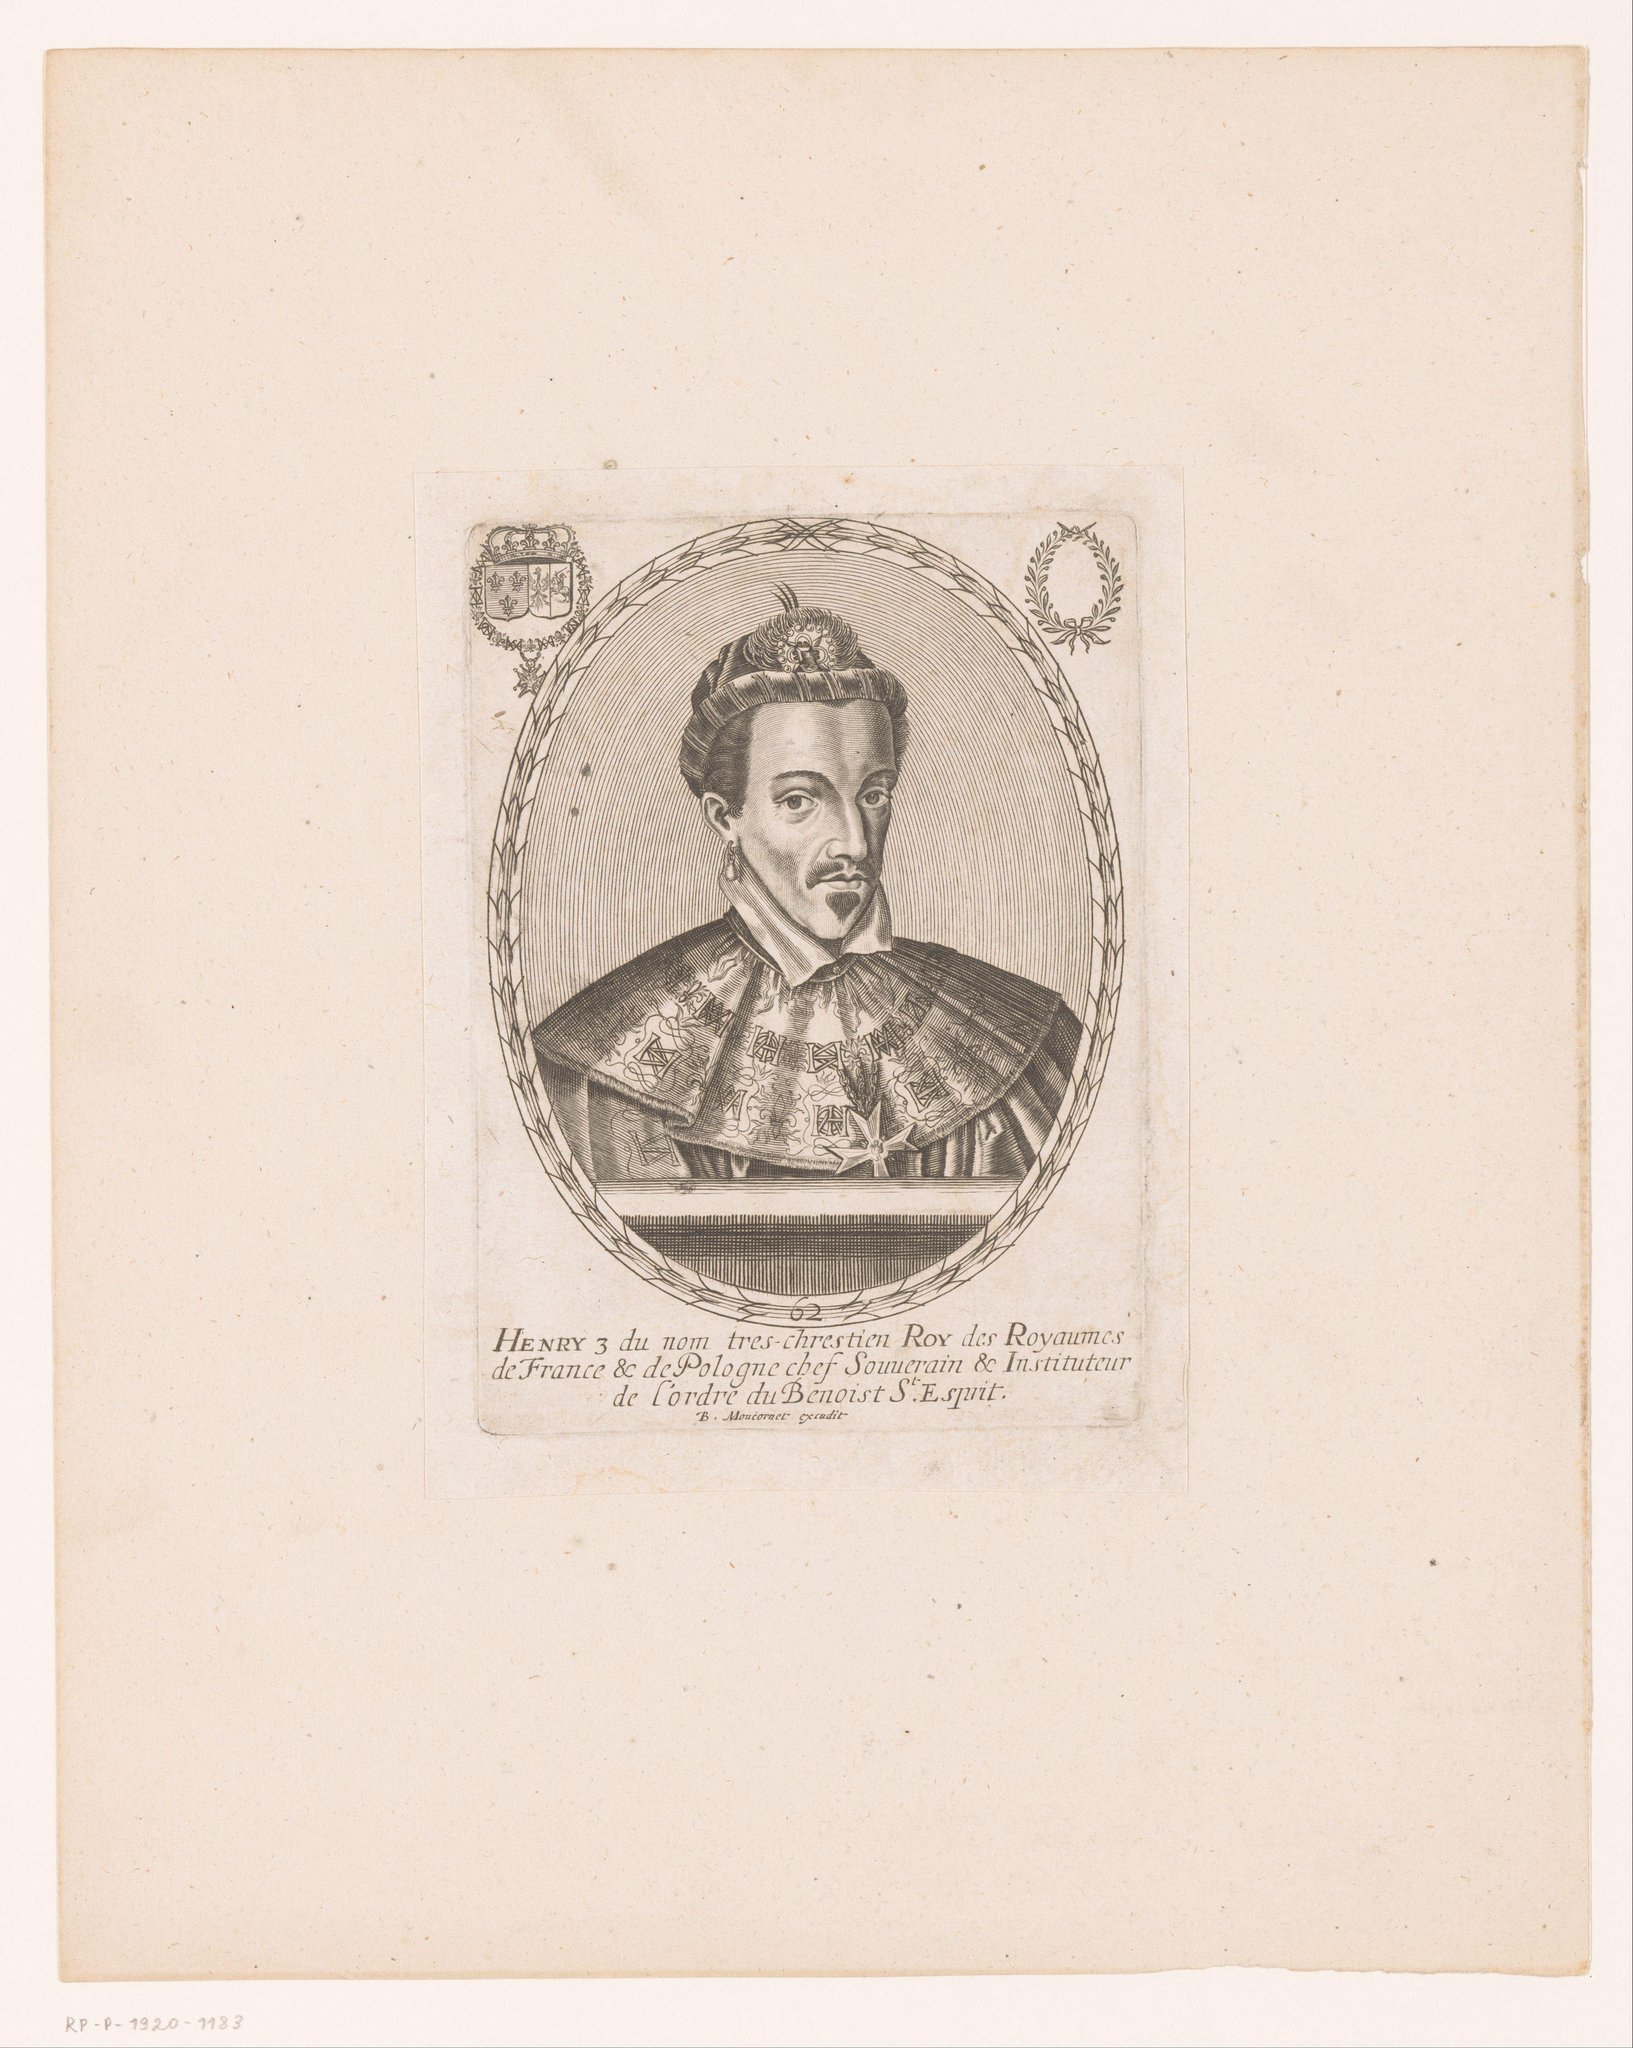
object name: print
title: Portret van Hendrik III van Frankrijk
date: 1610-1668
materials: paper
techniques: engraving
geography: paris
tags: hendrik iii (koning van frankrijk), historical persons, king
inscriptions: collector's mark: Lugt 2228